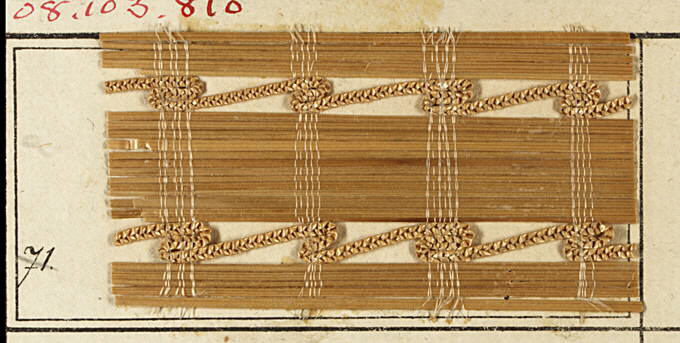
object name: ribbon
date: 1701-1900